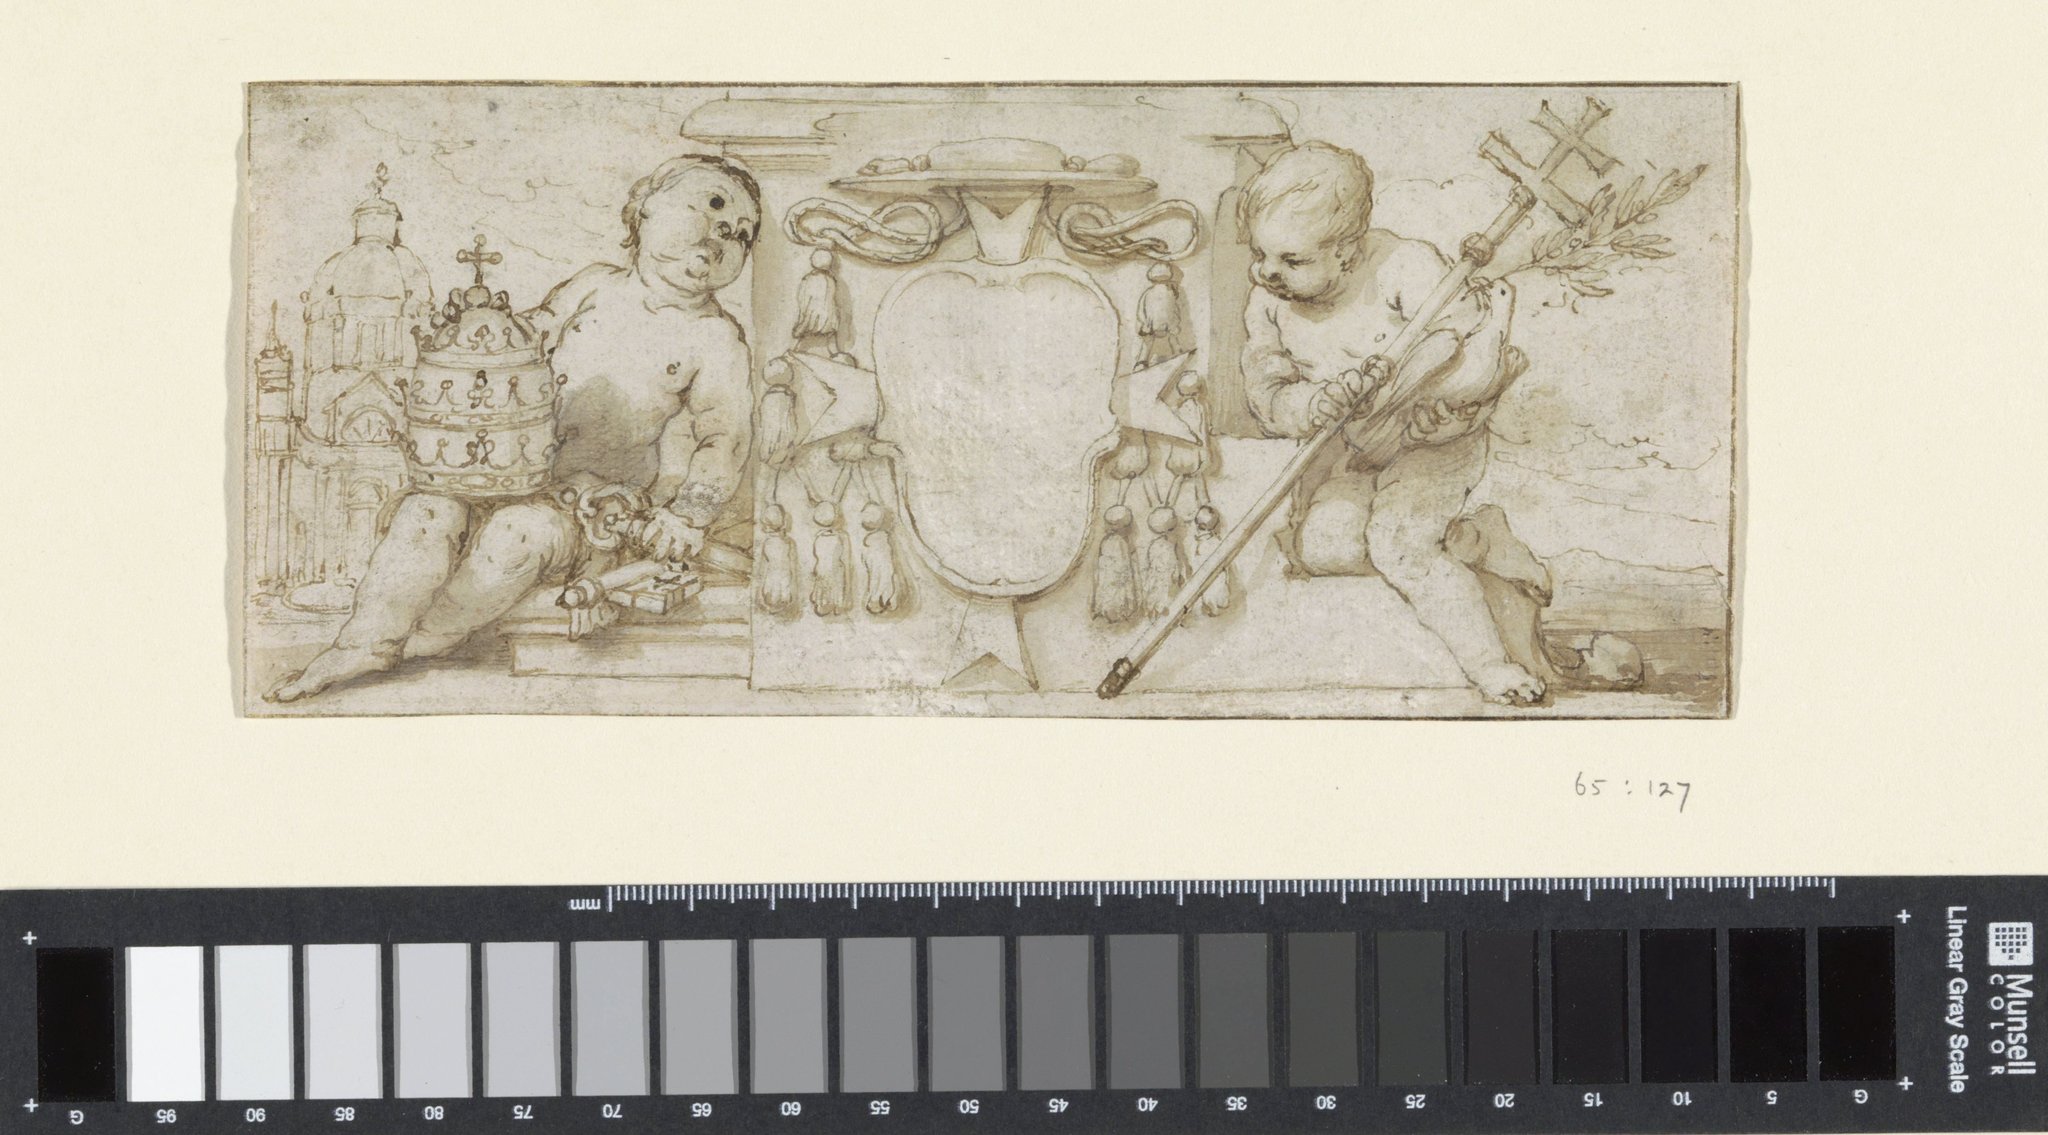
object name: design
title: Putti met wapenschild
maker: Anonymous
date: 1600-1699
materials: chalk, ink, paper, pencil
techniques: brush, pen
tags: armorial bearing, heraldry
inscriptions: collector's mark: Lugt 2228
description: Een wapenschild met links een putto met de pauselijke sleutels en tiara en rechts een putto met een kruisstaf en een duif met een tak. Links in de achtergrond een kerkgebouw. Ontwerp voor een prent.